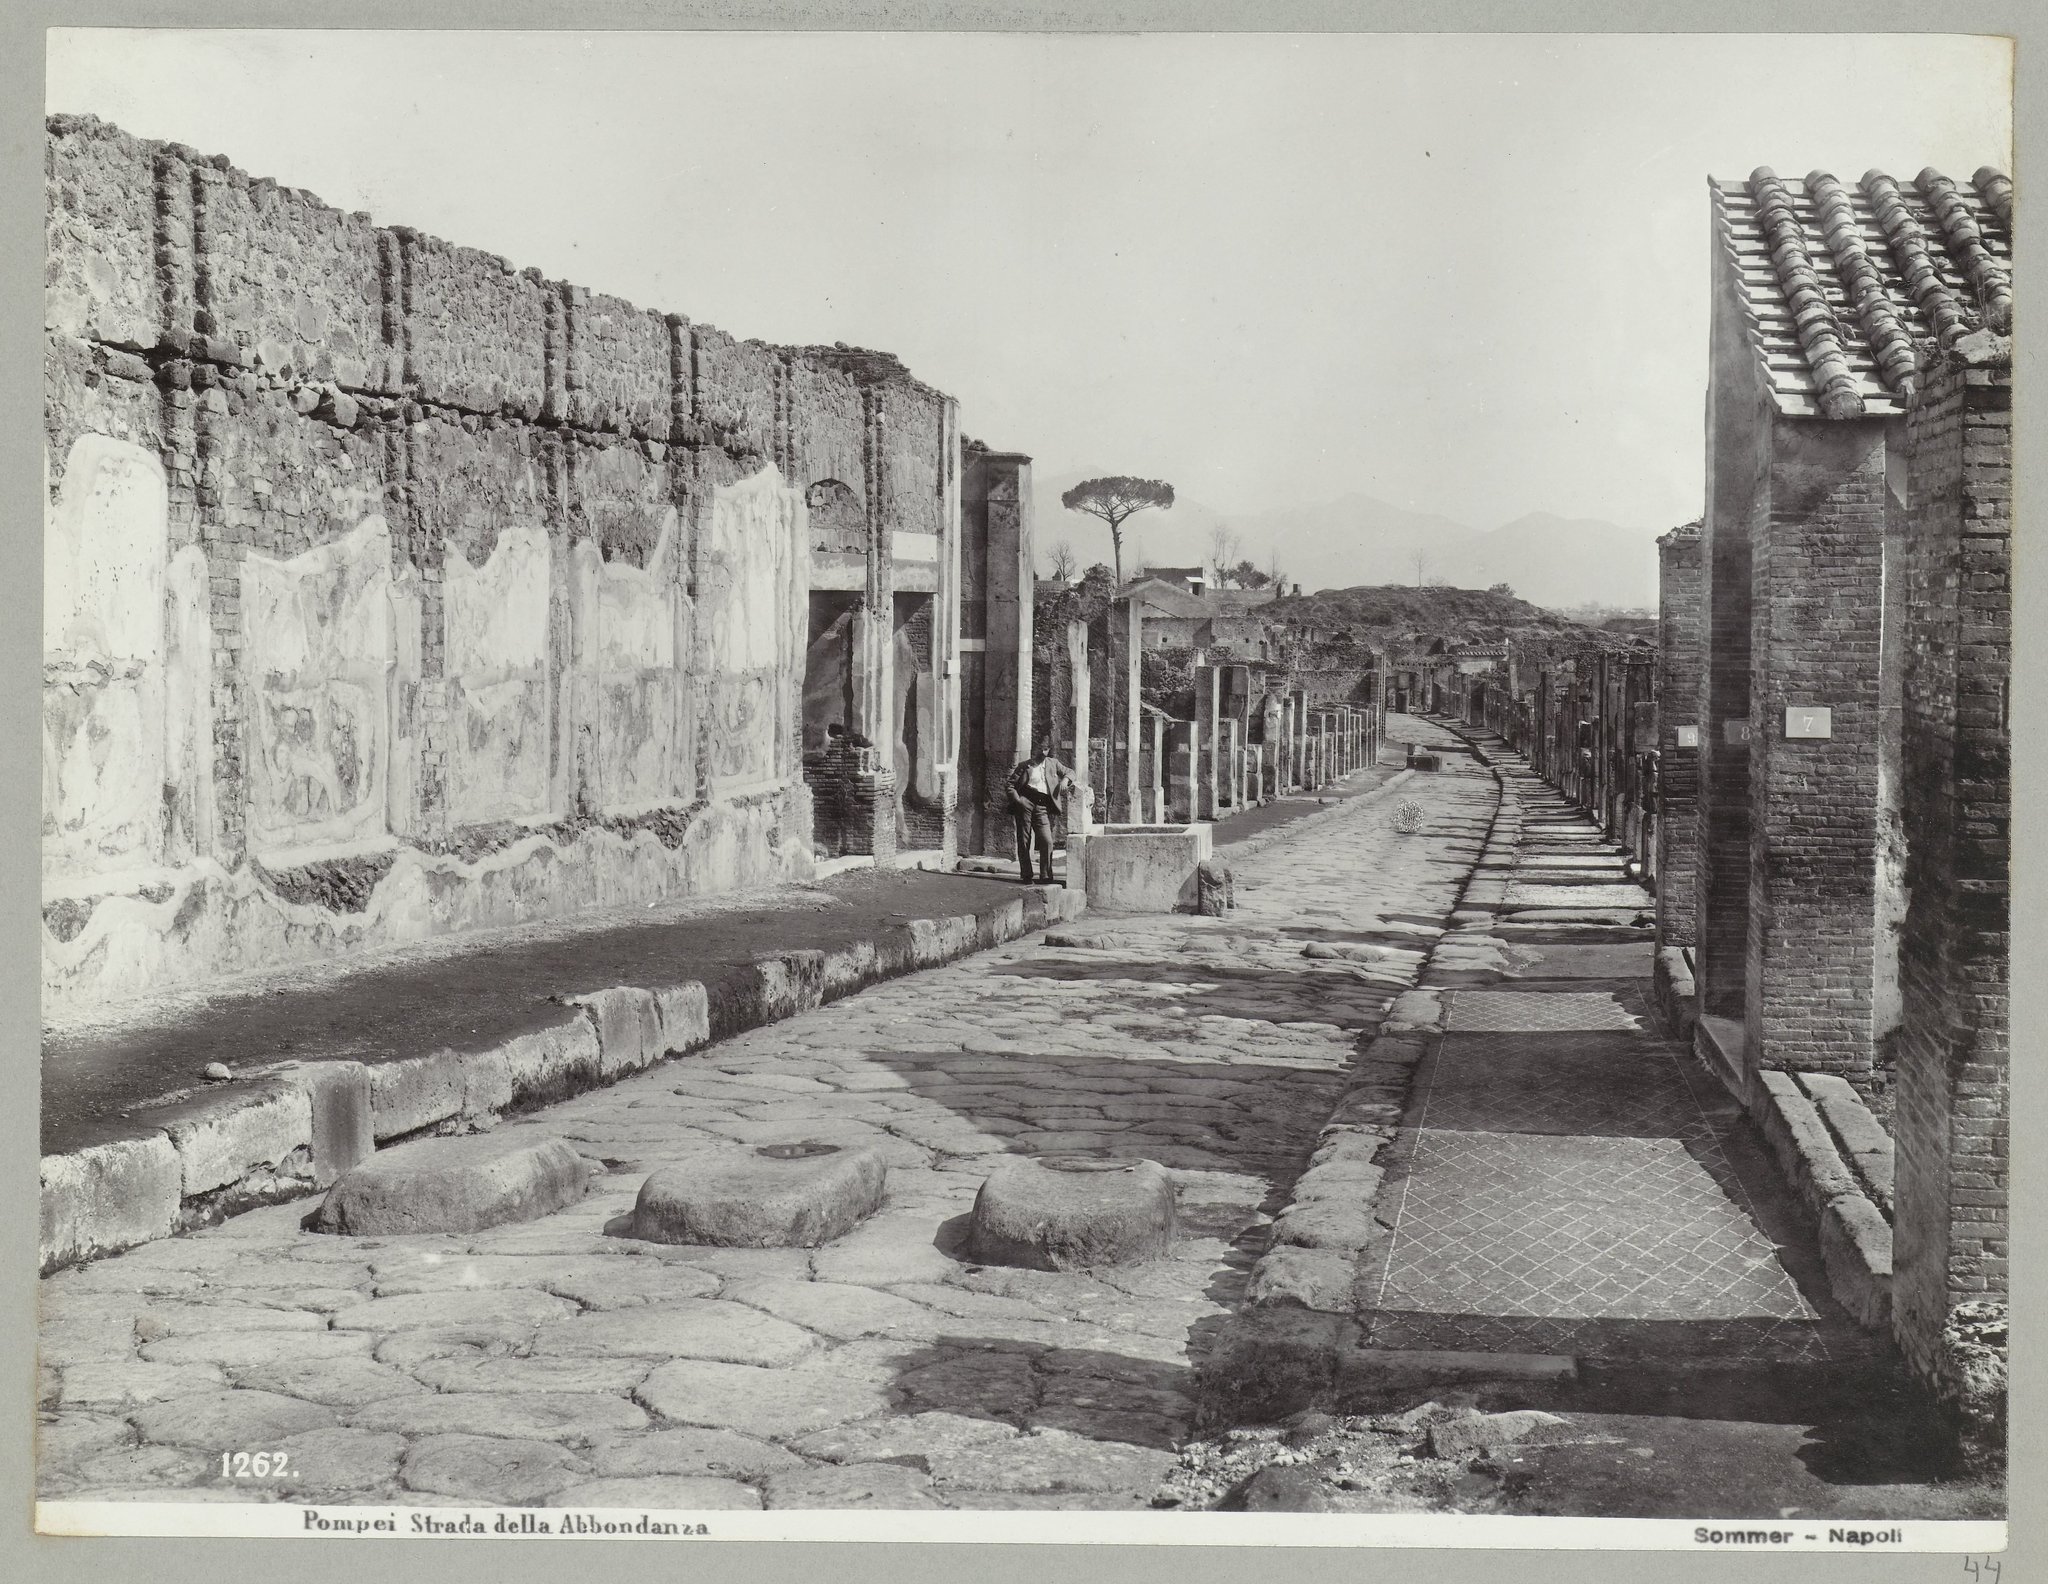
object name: photograph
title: Pompeï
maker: giorgio sommer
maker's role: fotograaf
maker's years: 1834-1914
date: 1888-1903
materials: cardboard, photographic support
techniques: albumen print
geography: netherlands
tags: pompeii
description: De ruïnes van de "straat des overvloeds" in Pompeï met aan weerszijden van de straat bebouwing.